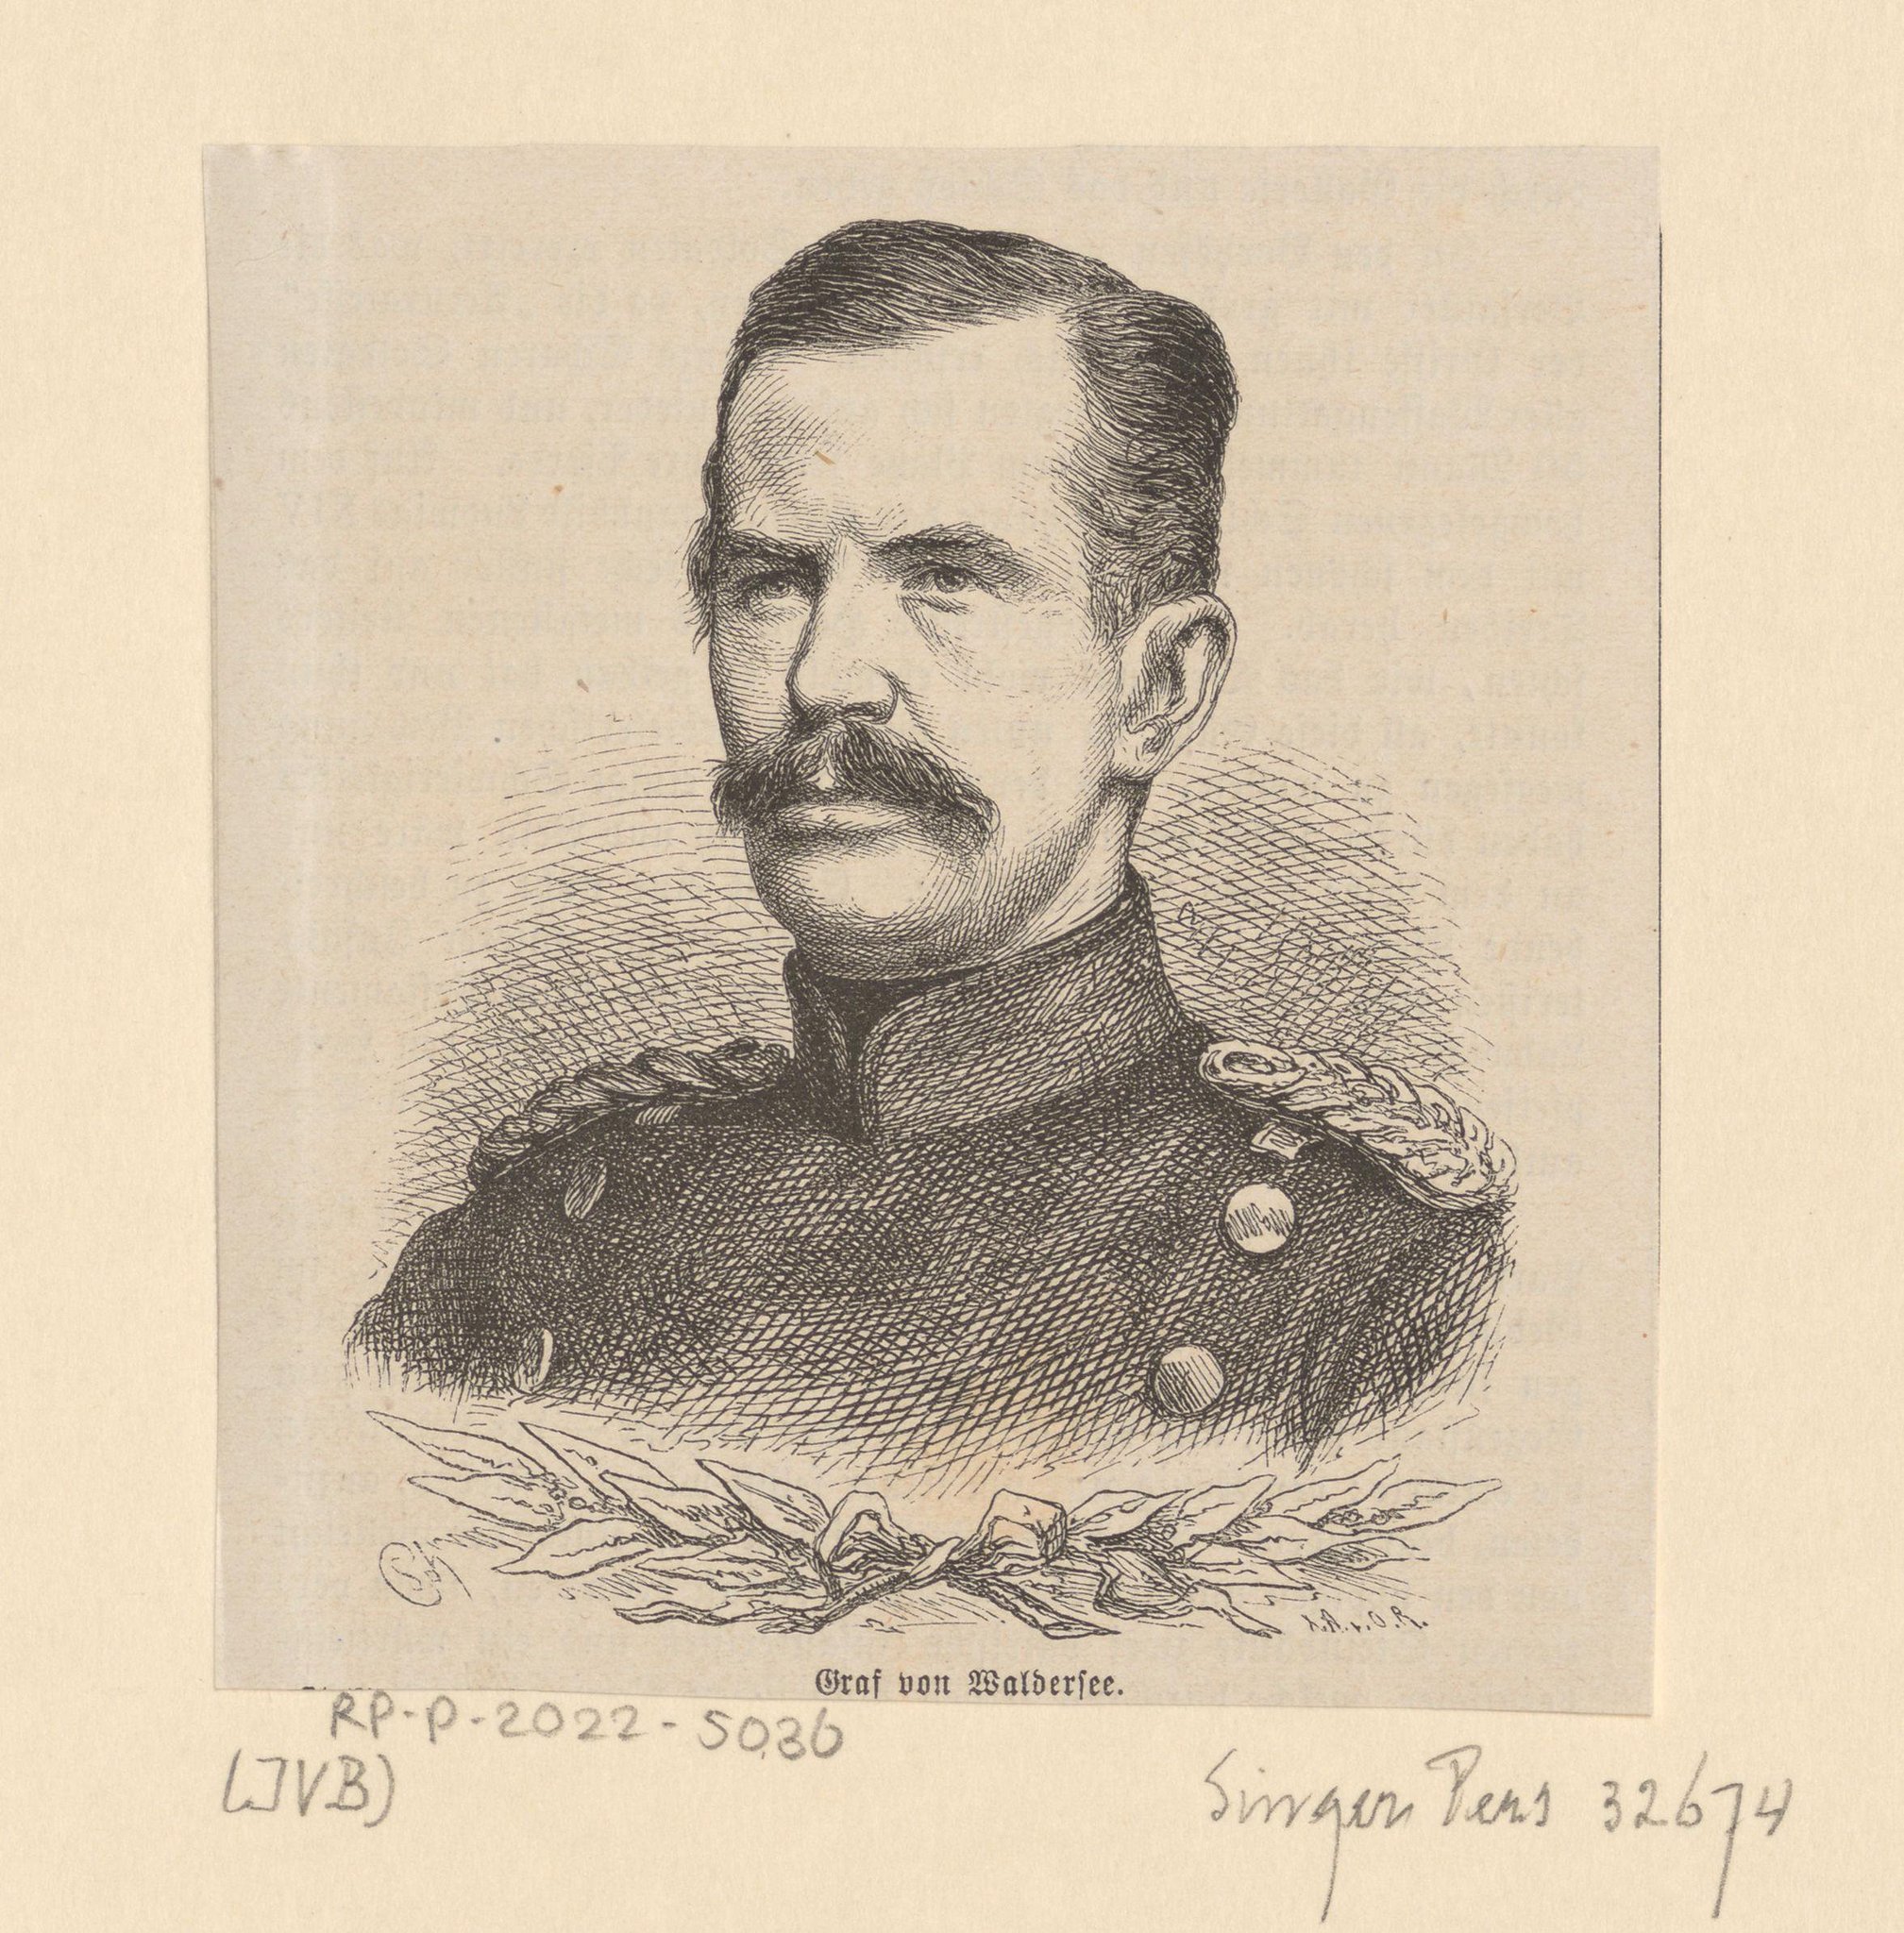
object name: print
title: Portret van Franz Heinrich von Waldersee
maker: Anonymous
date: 1850-1900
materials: paper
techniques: letterpress printing, engraving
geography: germany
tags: commander-in-chief, general, marshal, historical persons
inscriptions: stamp: ‘JVB’